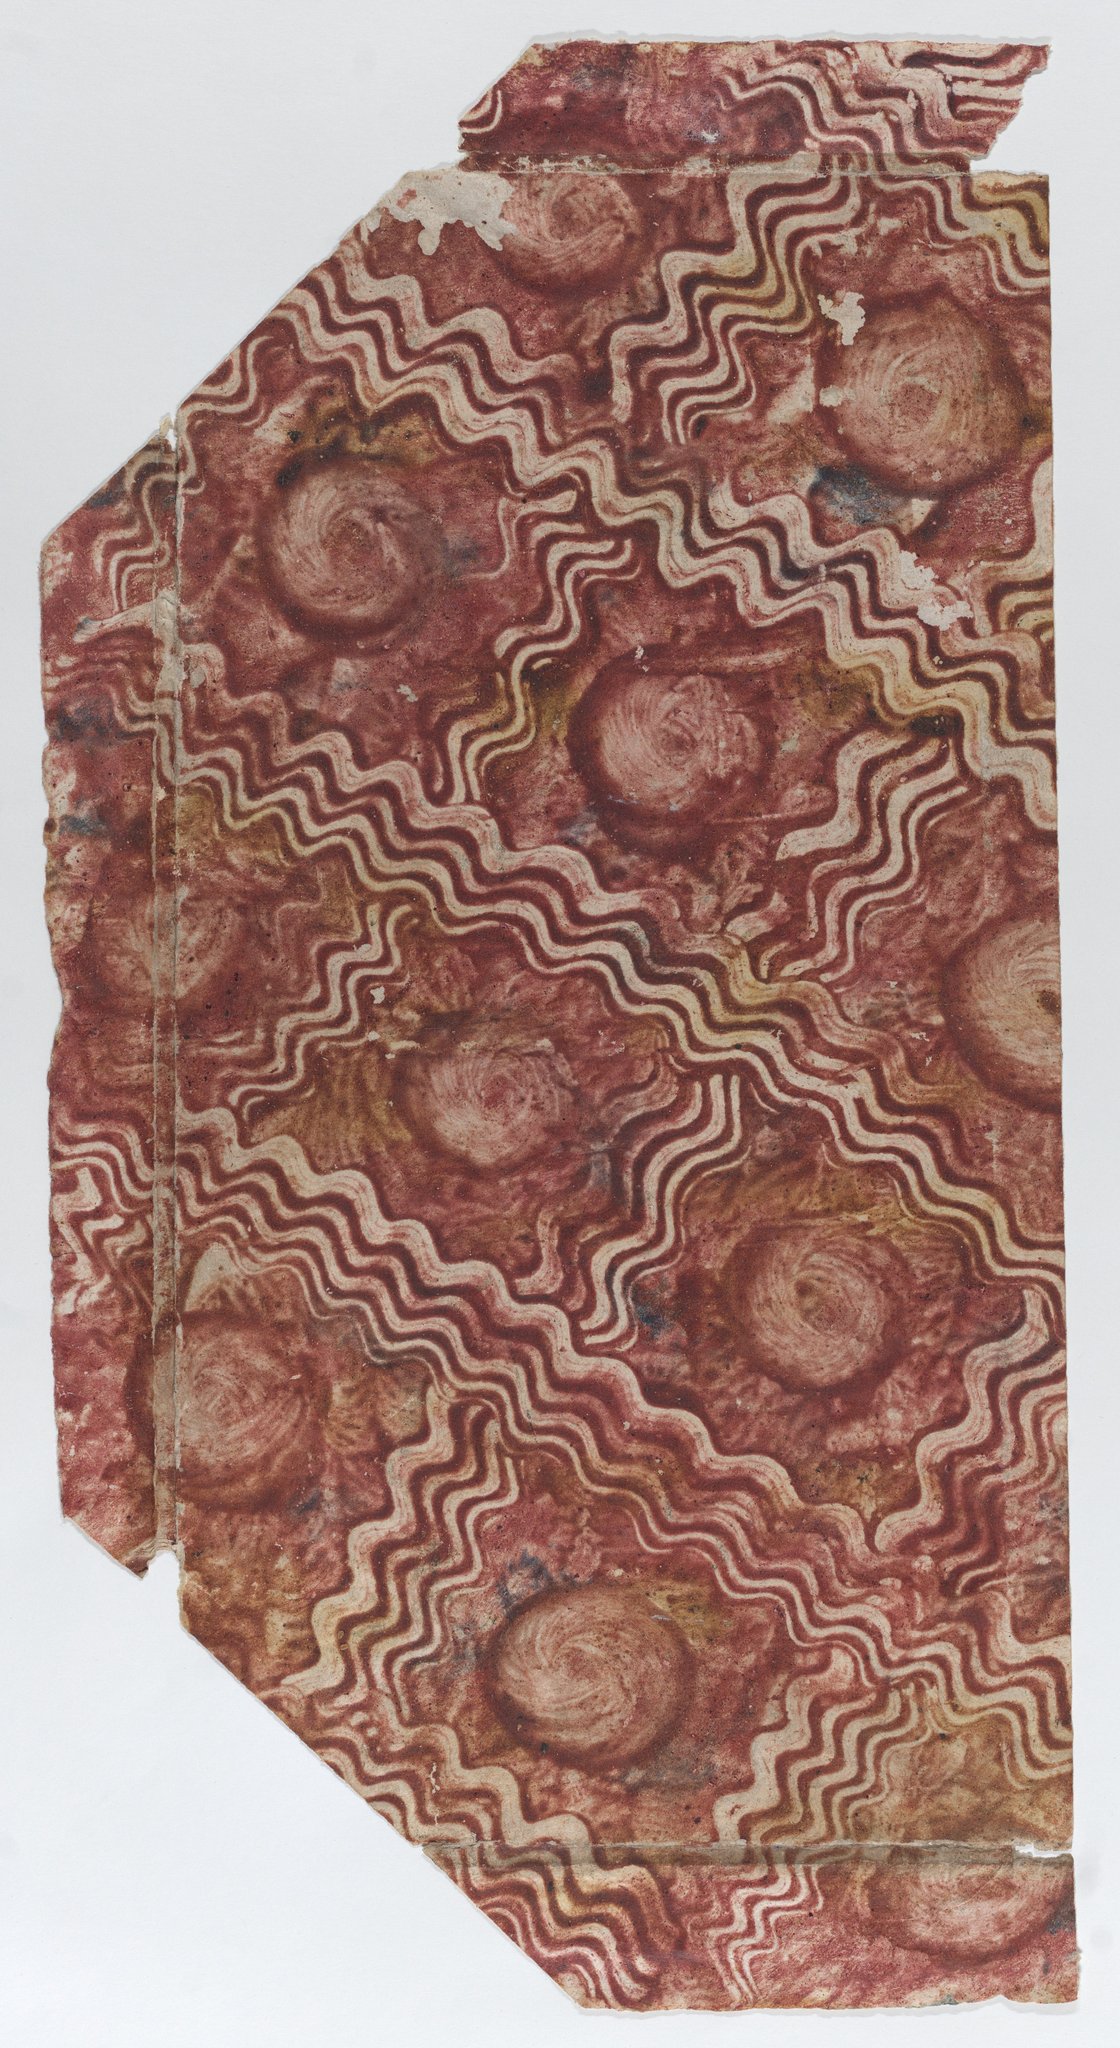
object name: print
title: Book cover with overall red curved line pattern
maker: Anonymous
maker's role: artist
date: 1801-1900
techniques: relief print